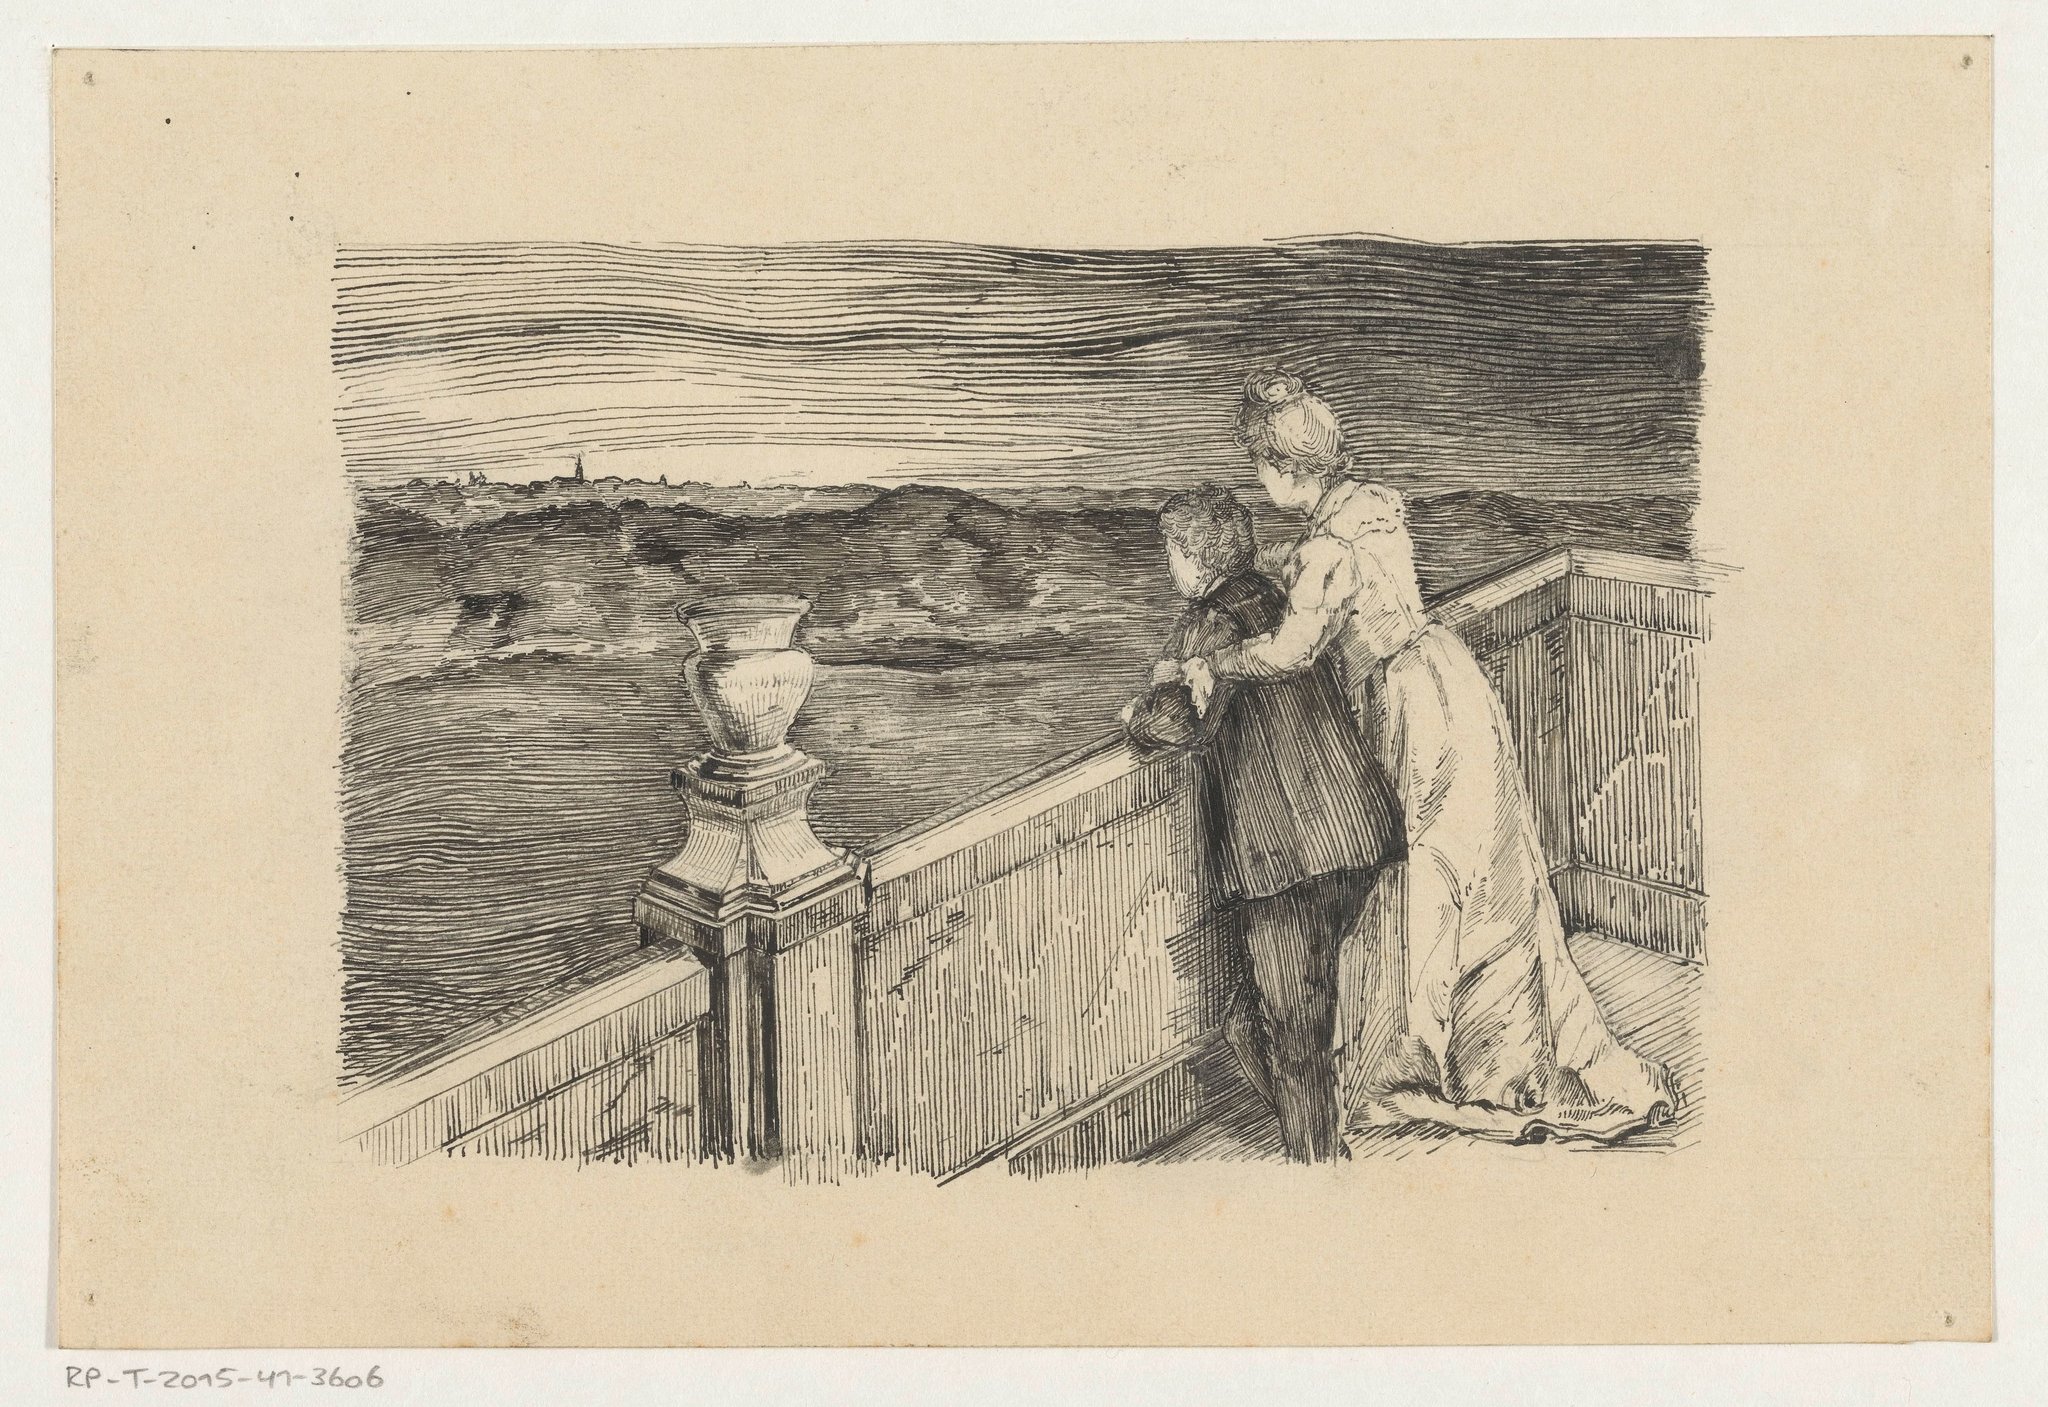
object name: boekillustratie ontwerp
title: Vrouw en jongen bij een balustrade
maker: Anonymous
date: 1880-1920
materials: ink, paper, pencil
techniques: pen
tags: city-view, and landscape with man-made constructions, balustrade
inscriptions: collector's mark: Lugt 2228a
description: De vrouw heeft haar arm om de schouder van de jongen geslagen en wijst in de verte. De twee kijken uit over een landschap met de contouren van een dorp met kerk.